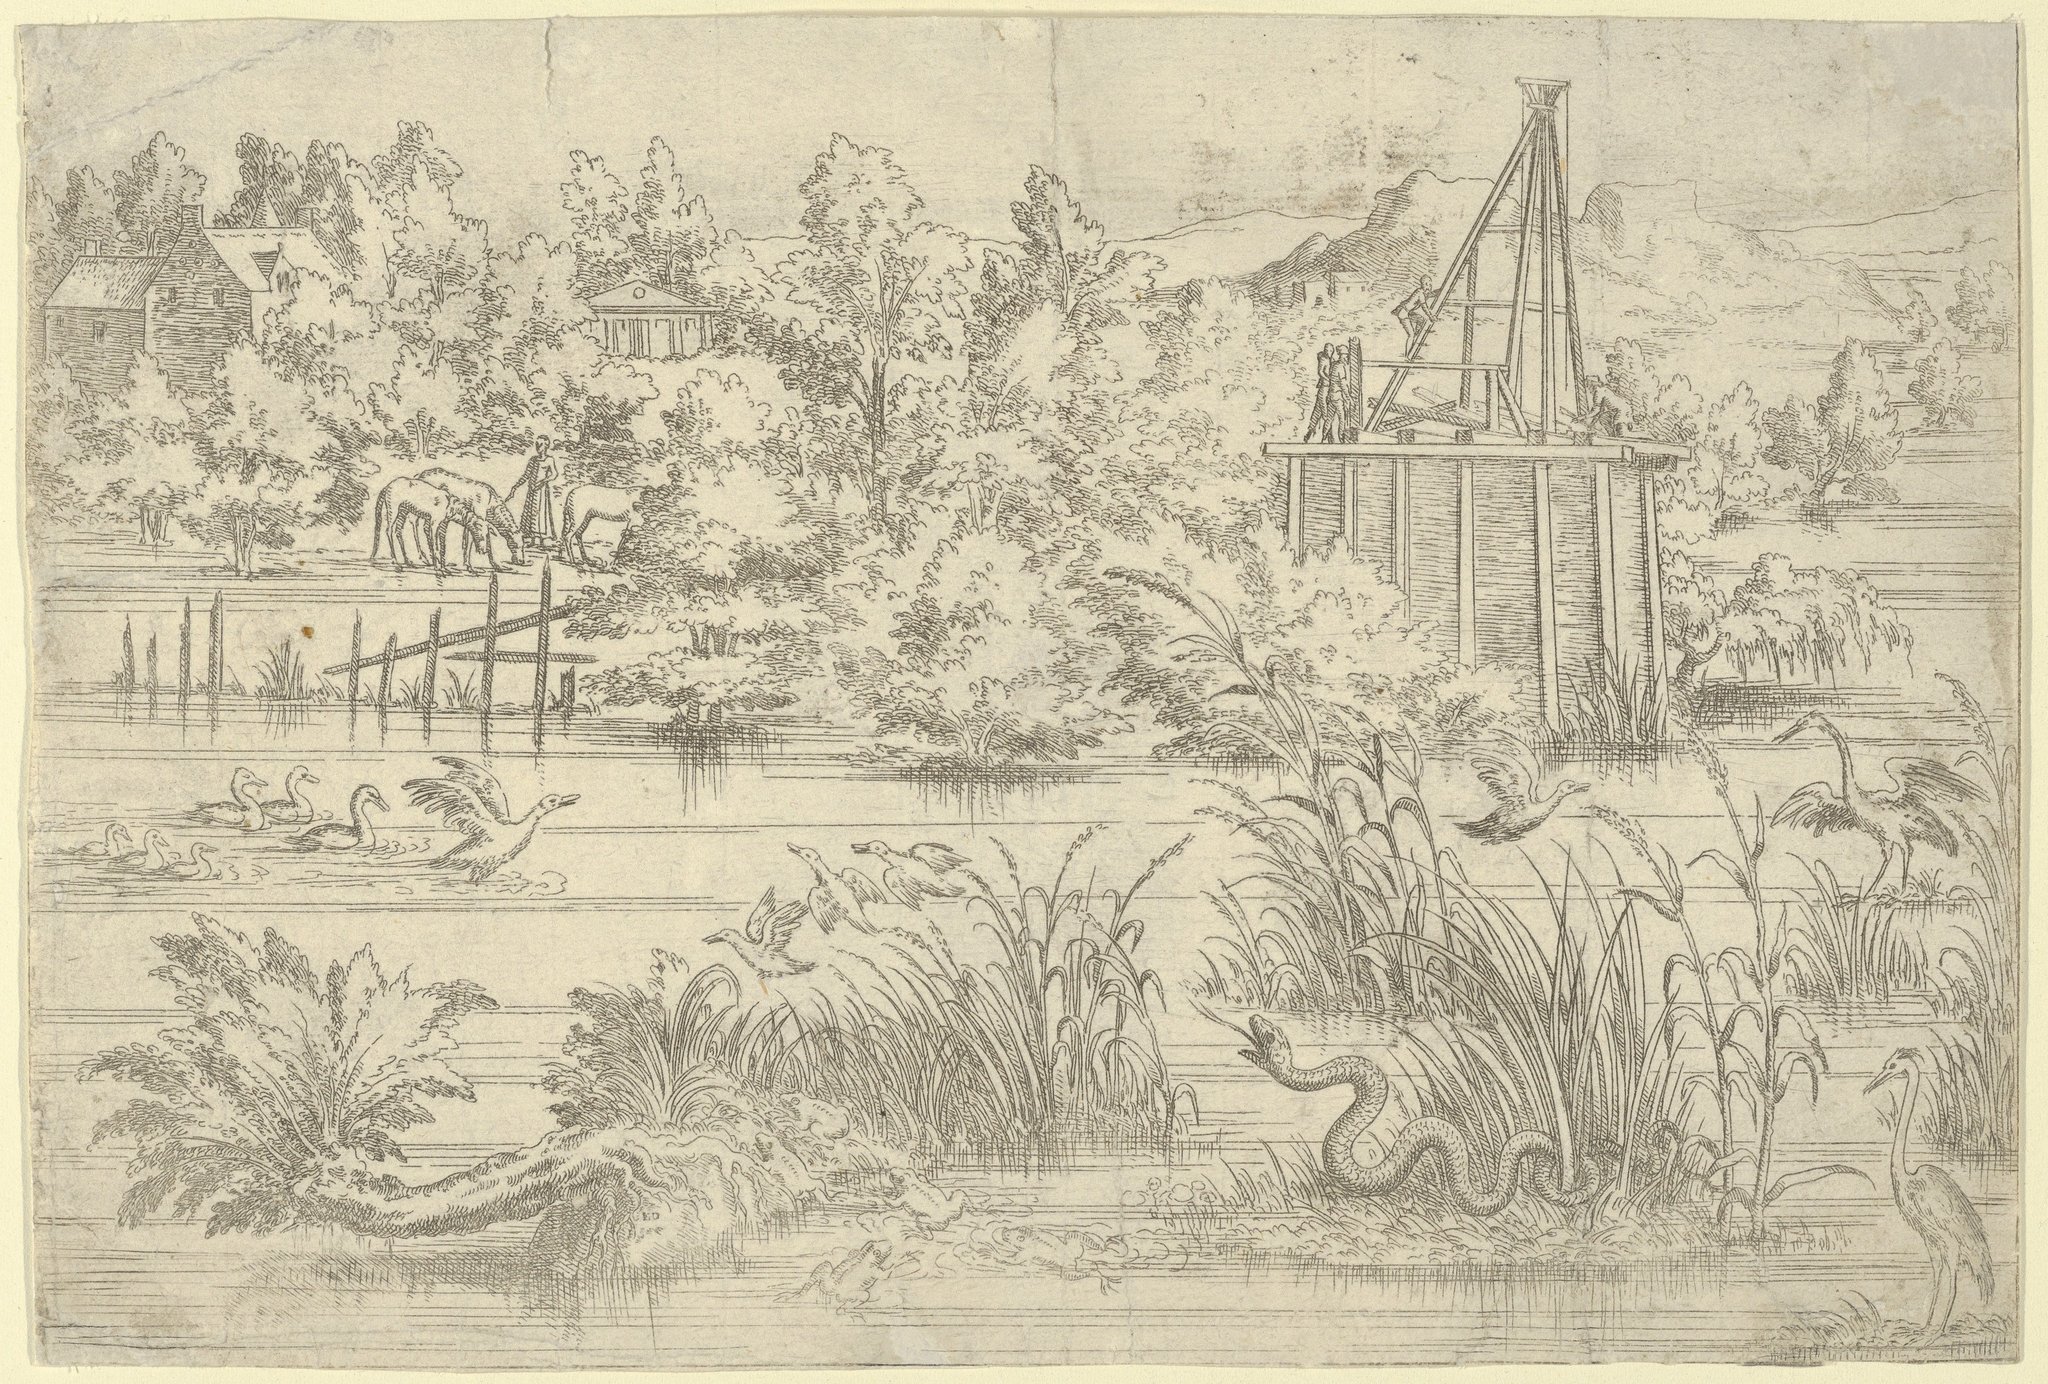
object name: print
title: Riverbank with Serpent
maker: léon davent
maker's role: artist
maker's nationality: french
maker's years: 1540-1556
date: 1540-1556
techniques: etching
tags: birds,serpents,rivers